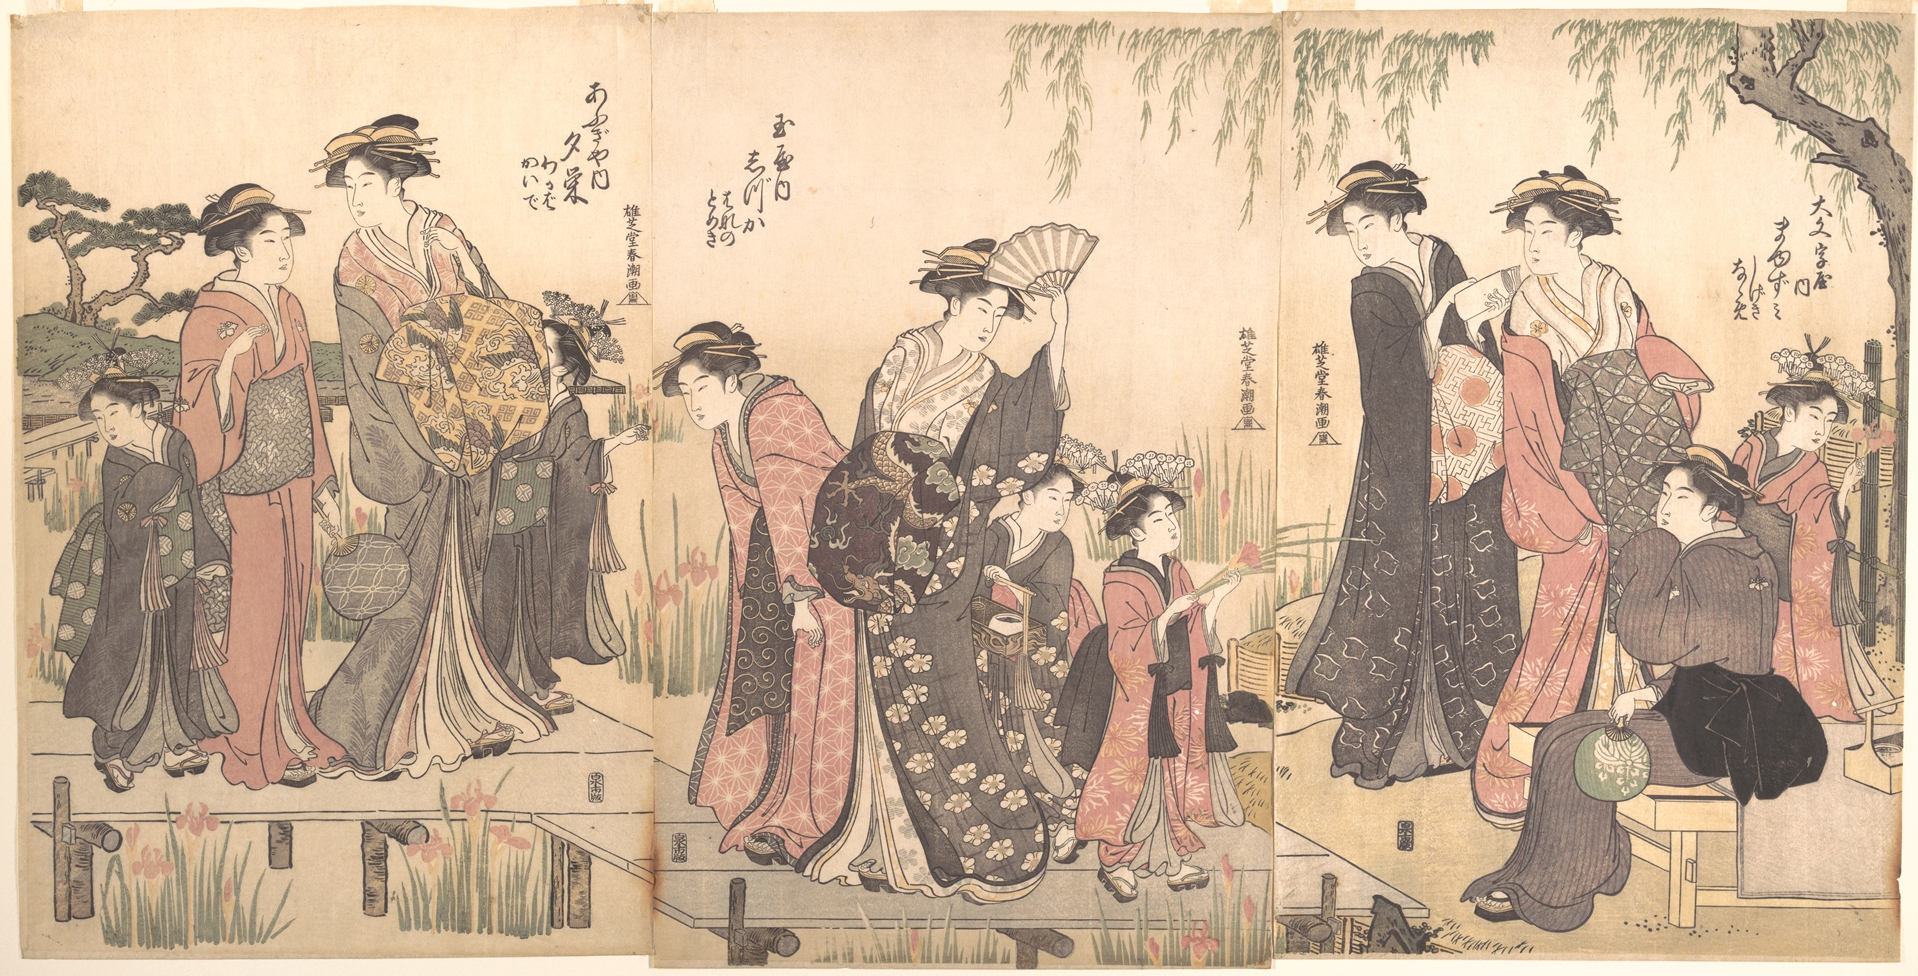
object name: print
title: Courtesans in an Iris Garden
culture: japanese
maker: katsukawa shunchō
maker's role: artist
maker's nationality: japanese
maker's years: 1775-1795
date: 1767-1800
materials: ink, paper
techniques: woodblock print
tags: gardens,girls,women